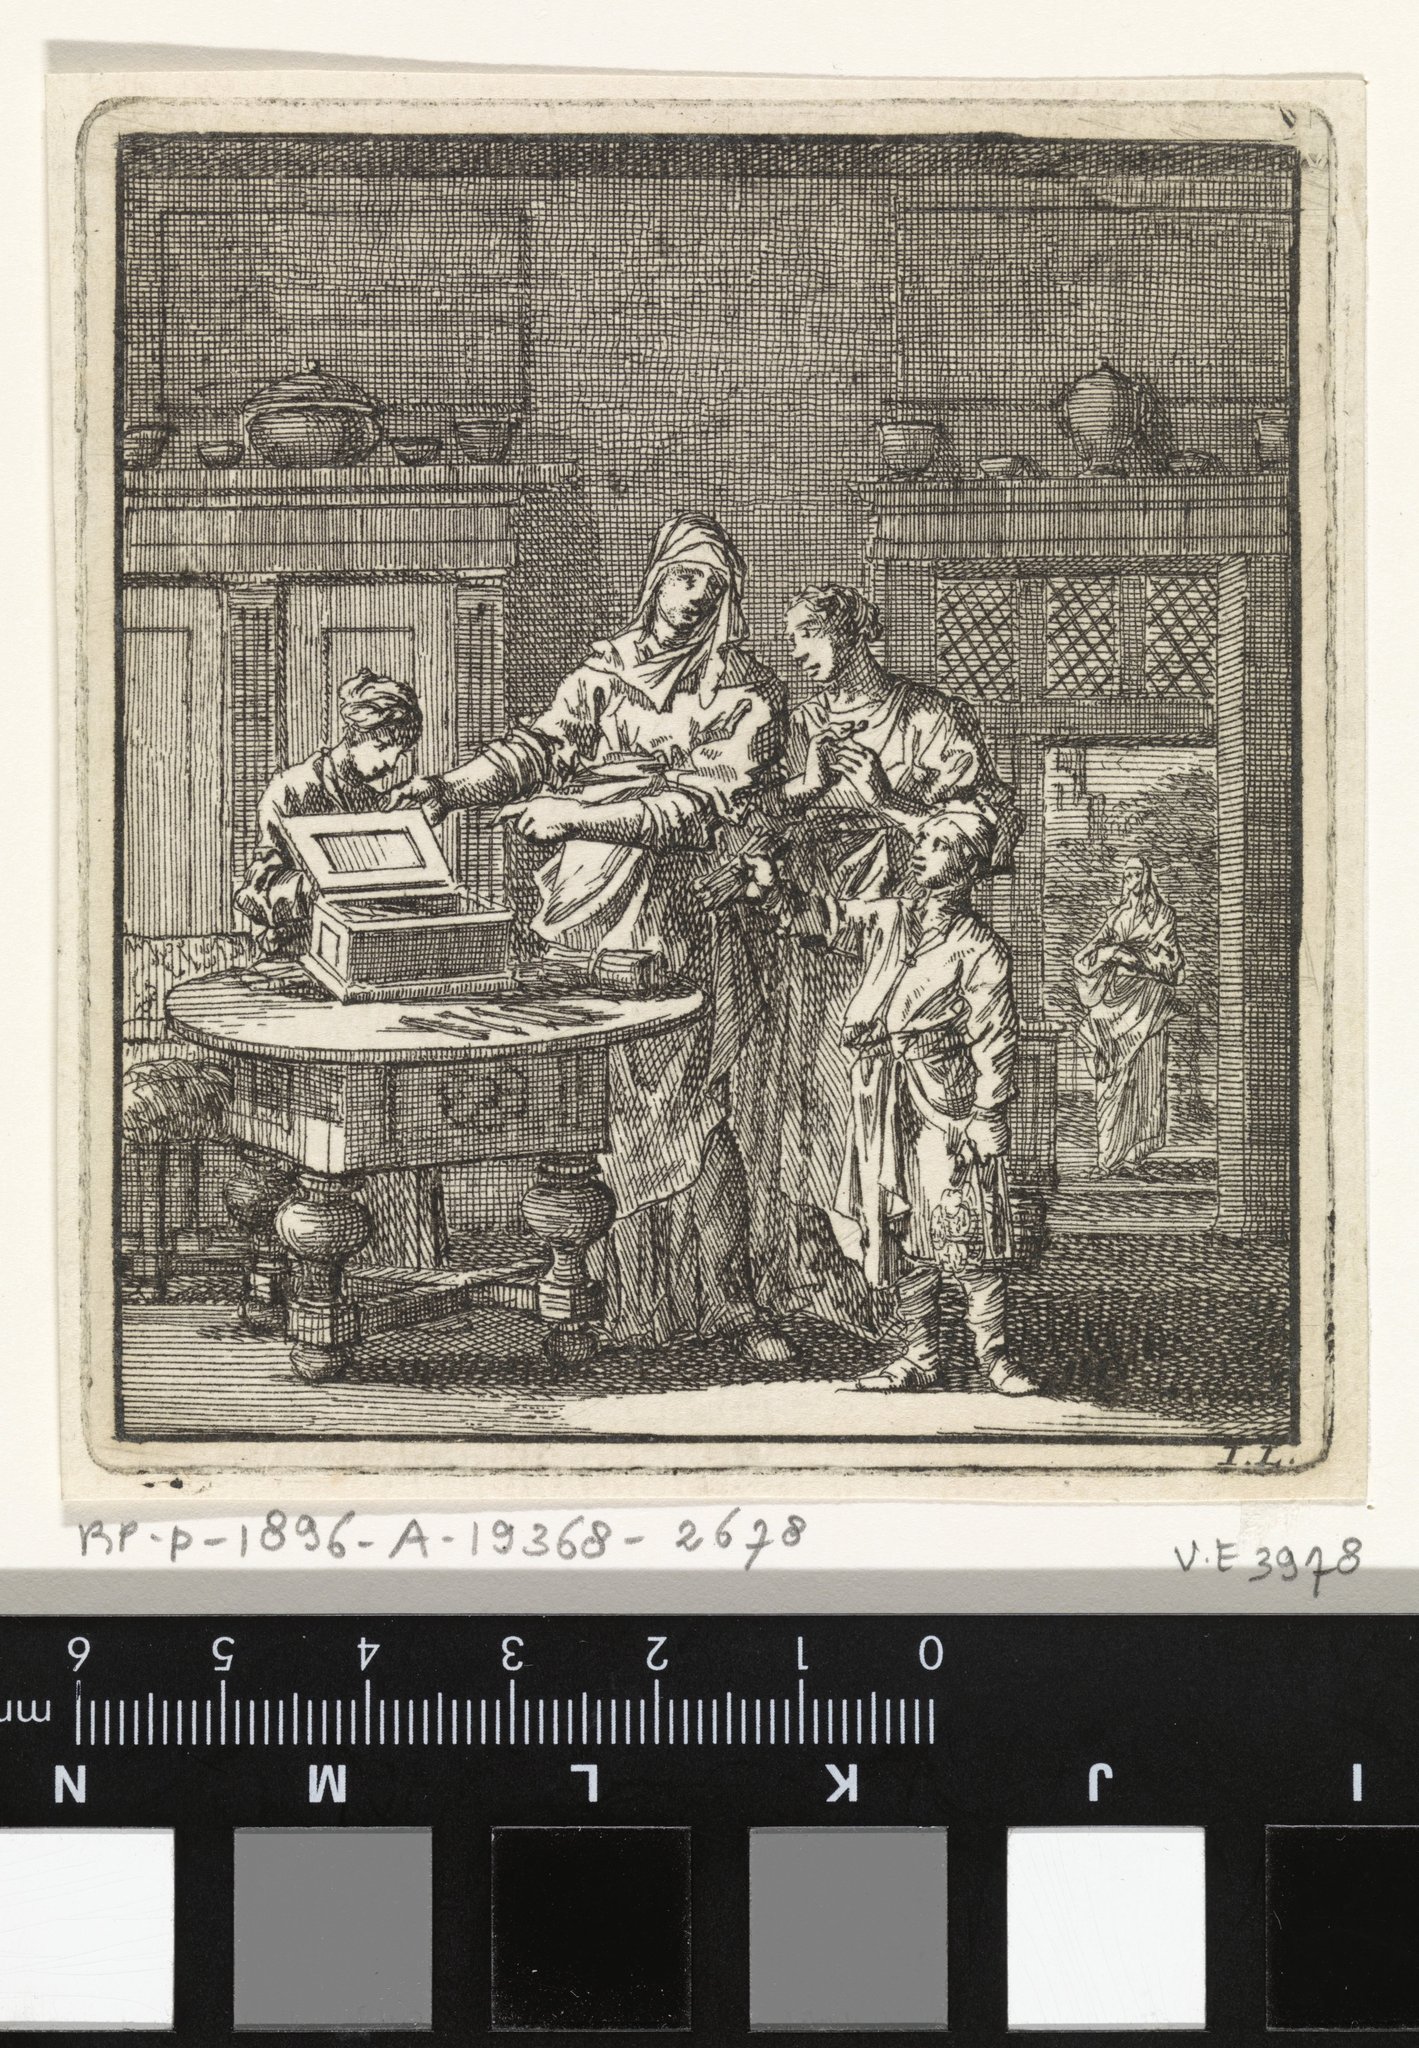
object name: book illustration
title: De Sulfer-bak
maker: jan luyken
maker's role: draughtsman, print maker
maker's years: 1649-1712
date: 1711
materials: paper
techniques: etching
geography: amsterdam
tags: minerals and metals: sulphur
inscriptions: collector's mark: Lugt 2228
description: Illustratie voor: Luyken, Jan. Het leerzaam huisraad, vertoond in vyftig konstige figuuren, met godlyke spreuken en stichtelyke verzen: Pieter Arentsz. II (wed.) en Cornelis van der Sys, 1711, p. 96.